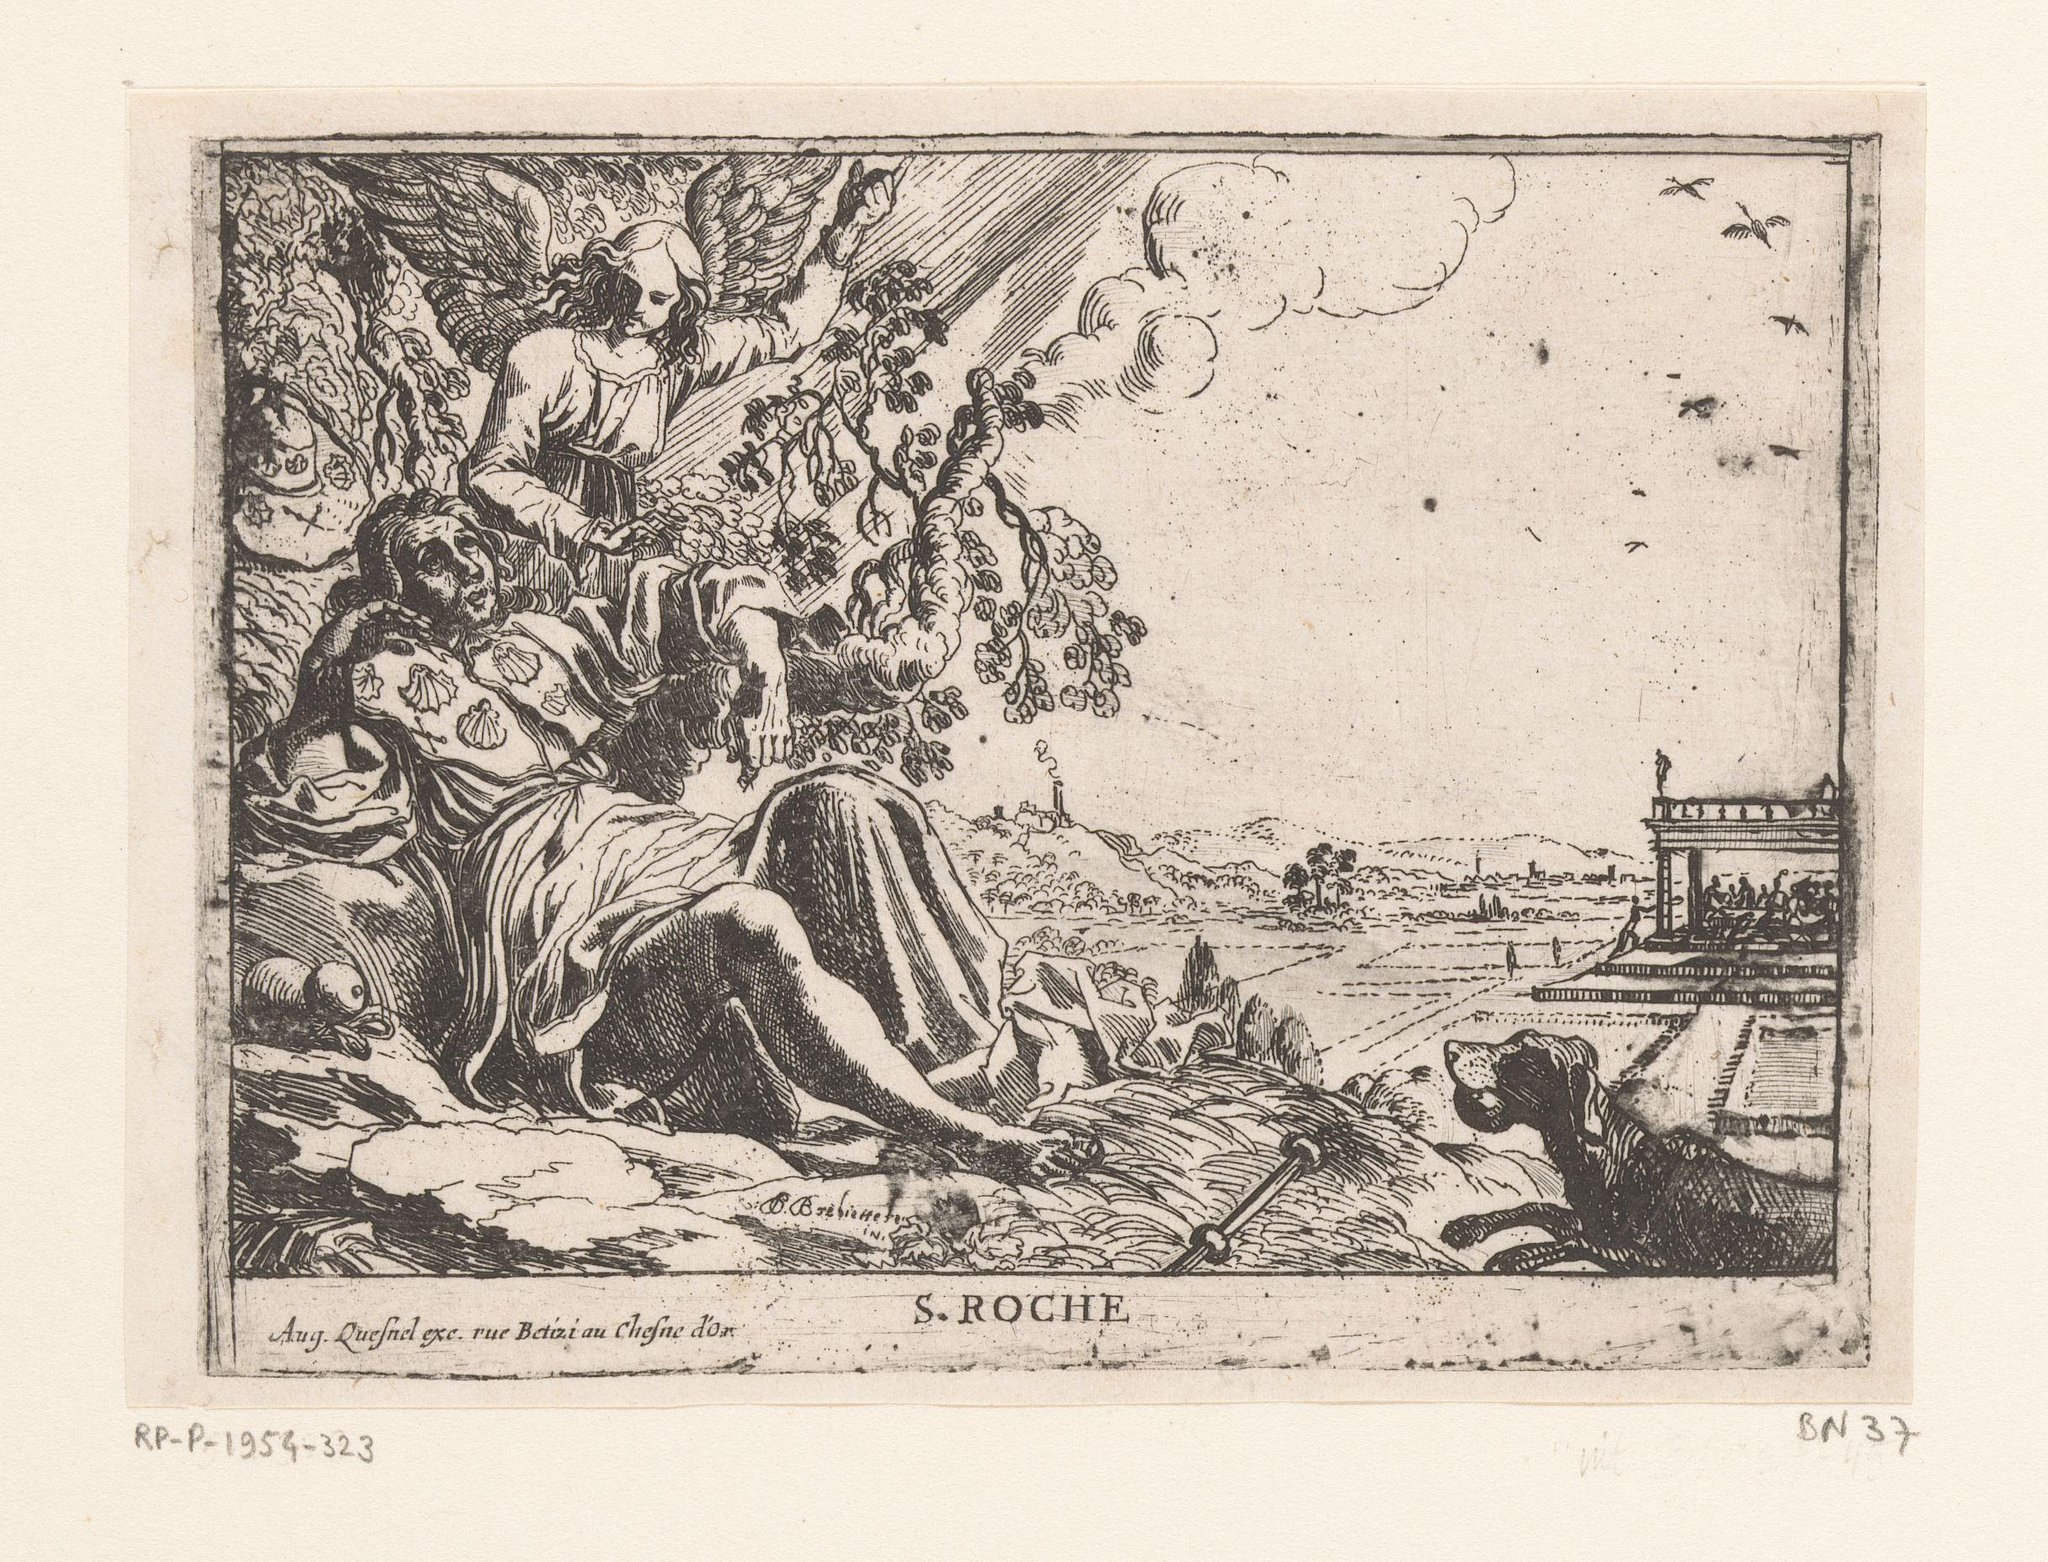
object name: print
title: Heilige Rochus van Montpellier in een landschap met hond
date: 1608-1650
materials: paper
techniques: etching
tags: the confessor and pilgrim roch(us) (rocco, rock) of montpellier; possible attributes: angel (with ointment box or spoon), dog (sometimes with loaf), (pointing at) plague-spot on thigh, pilgrim's shell, staff, hat and wallet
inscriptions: collector's mark: Lugt 2228, collector's mark: Lugt 2760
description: Maakt deel uit van een serie van negentien prenten van heiligen.